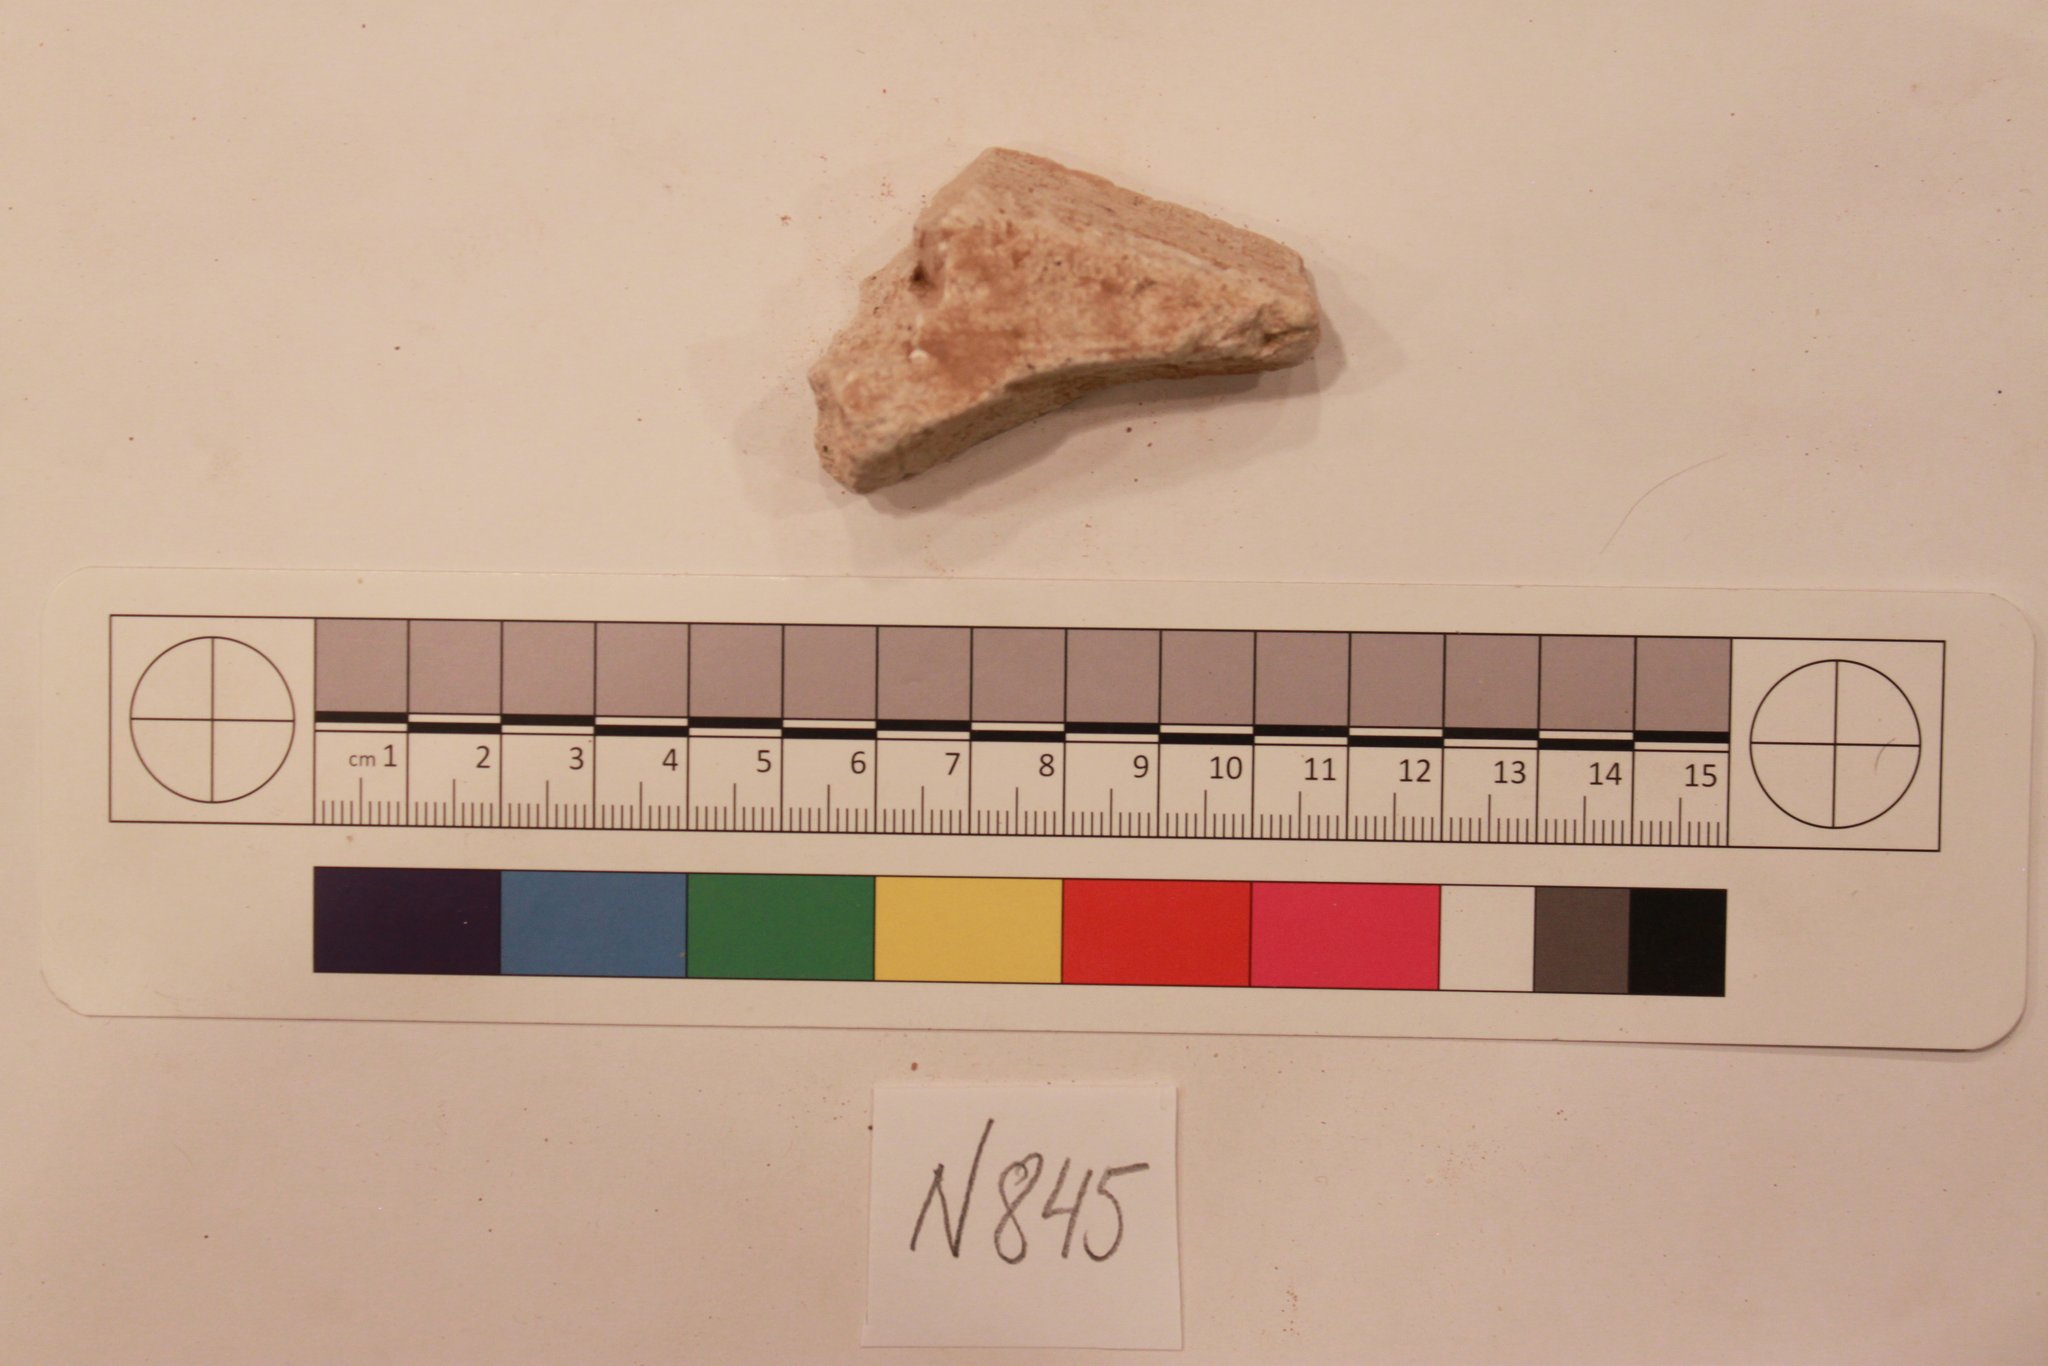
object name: fragment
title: Stucco Fragment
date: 701-1200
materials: plaster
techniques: carving, painting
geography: iran